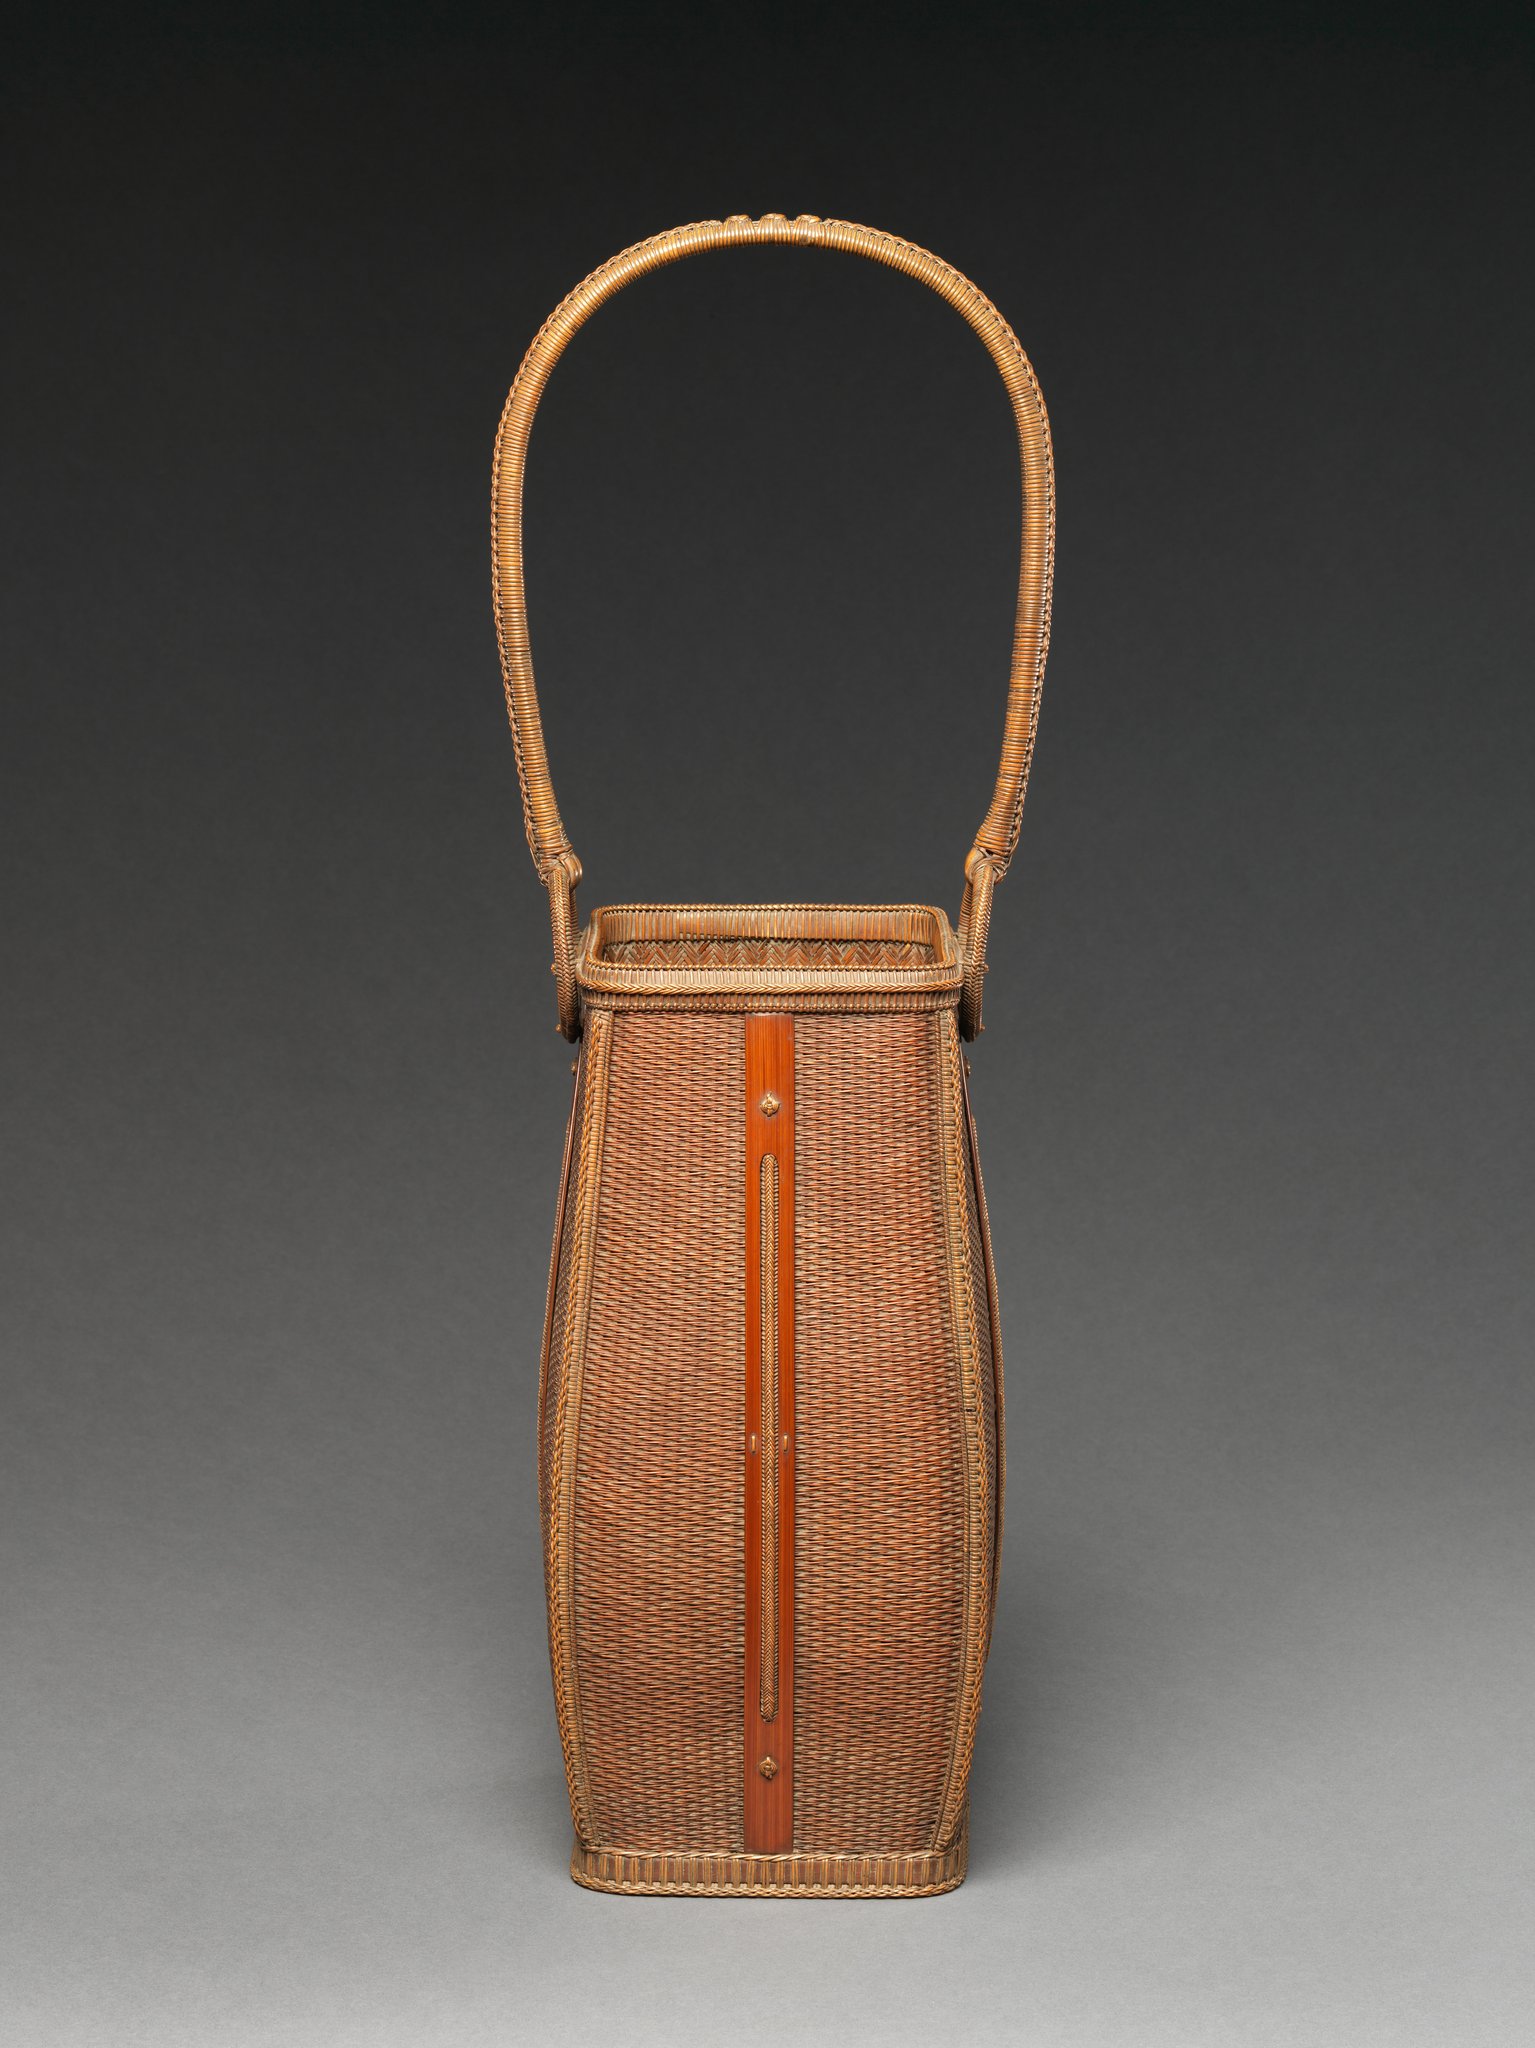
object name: basket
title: Chinese-Style Flower Basket (Karamono hanakago)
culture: japanese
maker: wada waichisai i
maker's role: artist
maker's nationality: japanese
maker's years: 1851-1901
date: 1890-1901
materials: bamboo, lacquer, rattan